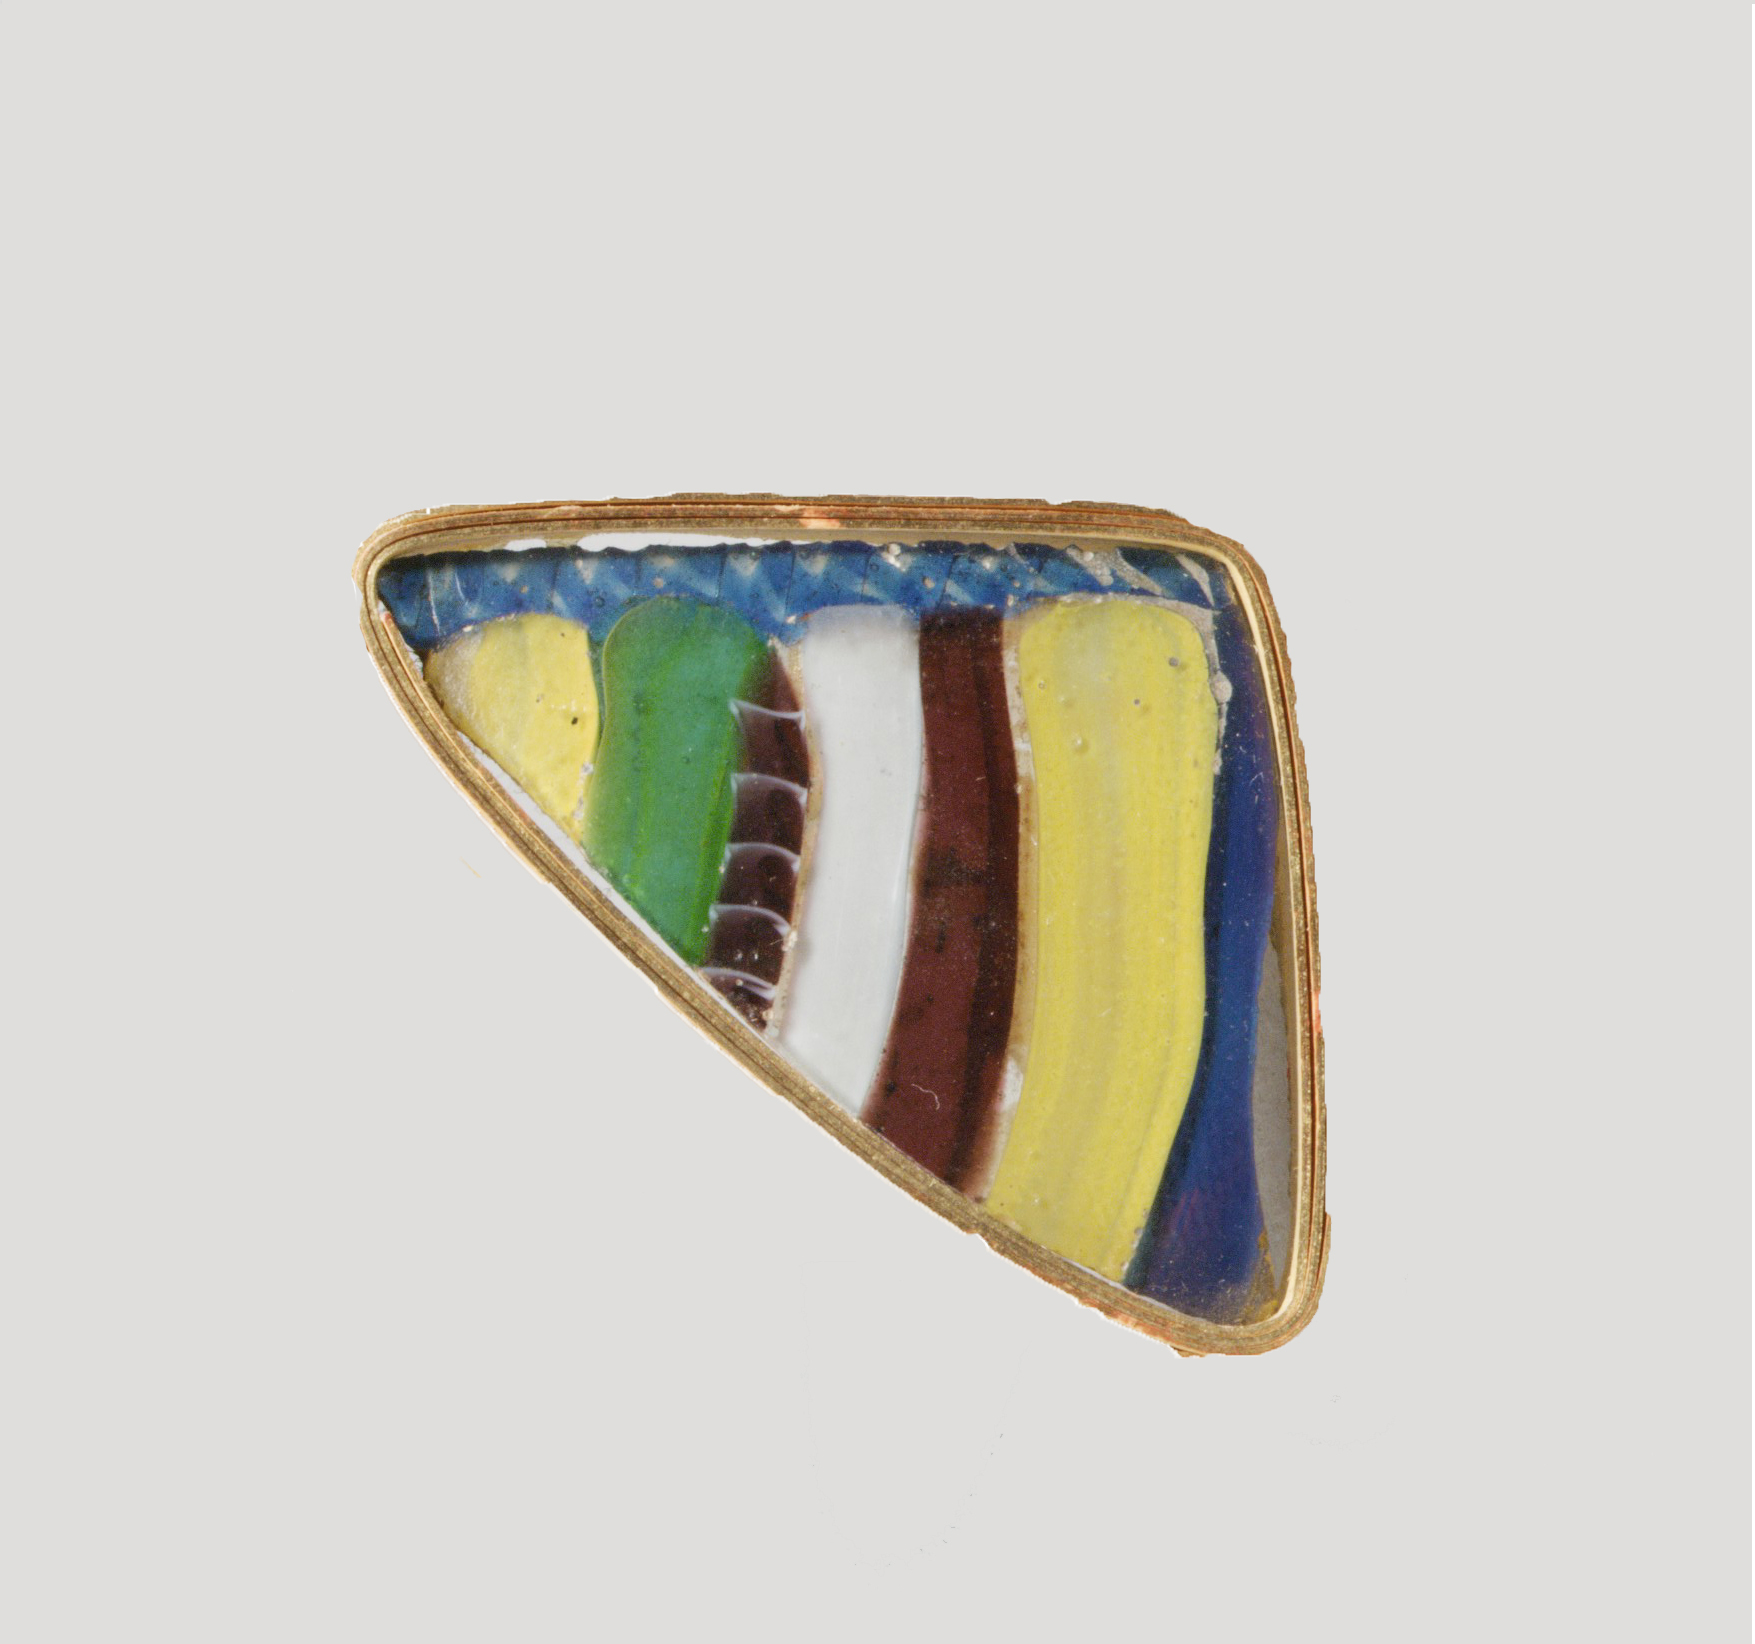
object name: fragment, striped mosaic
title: Glass striped mosaic bowl fragment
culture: roman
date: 34 BCE-33 CE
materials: glass